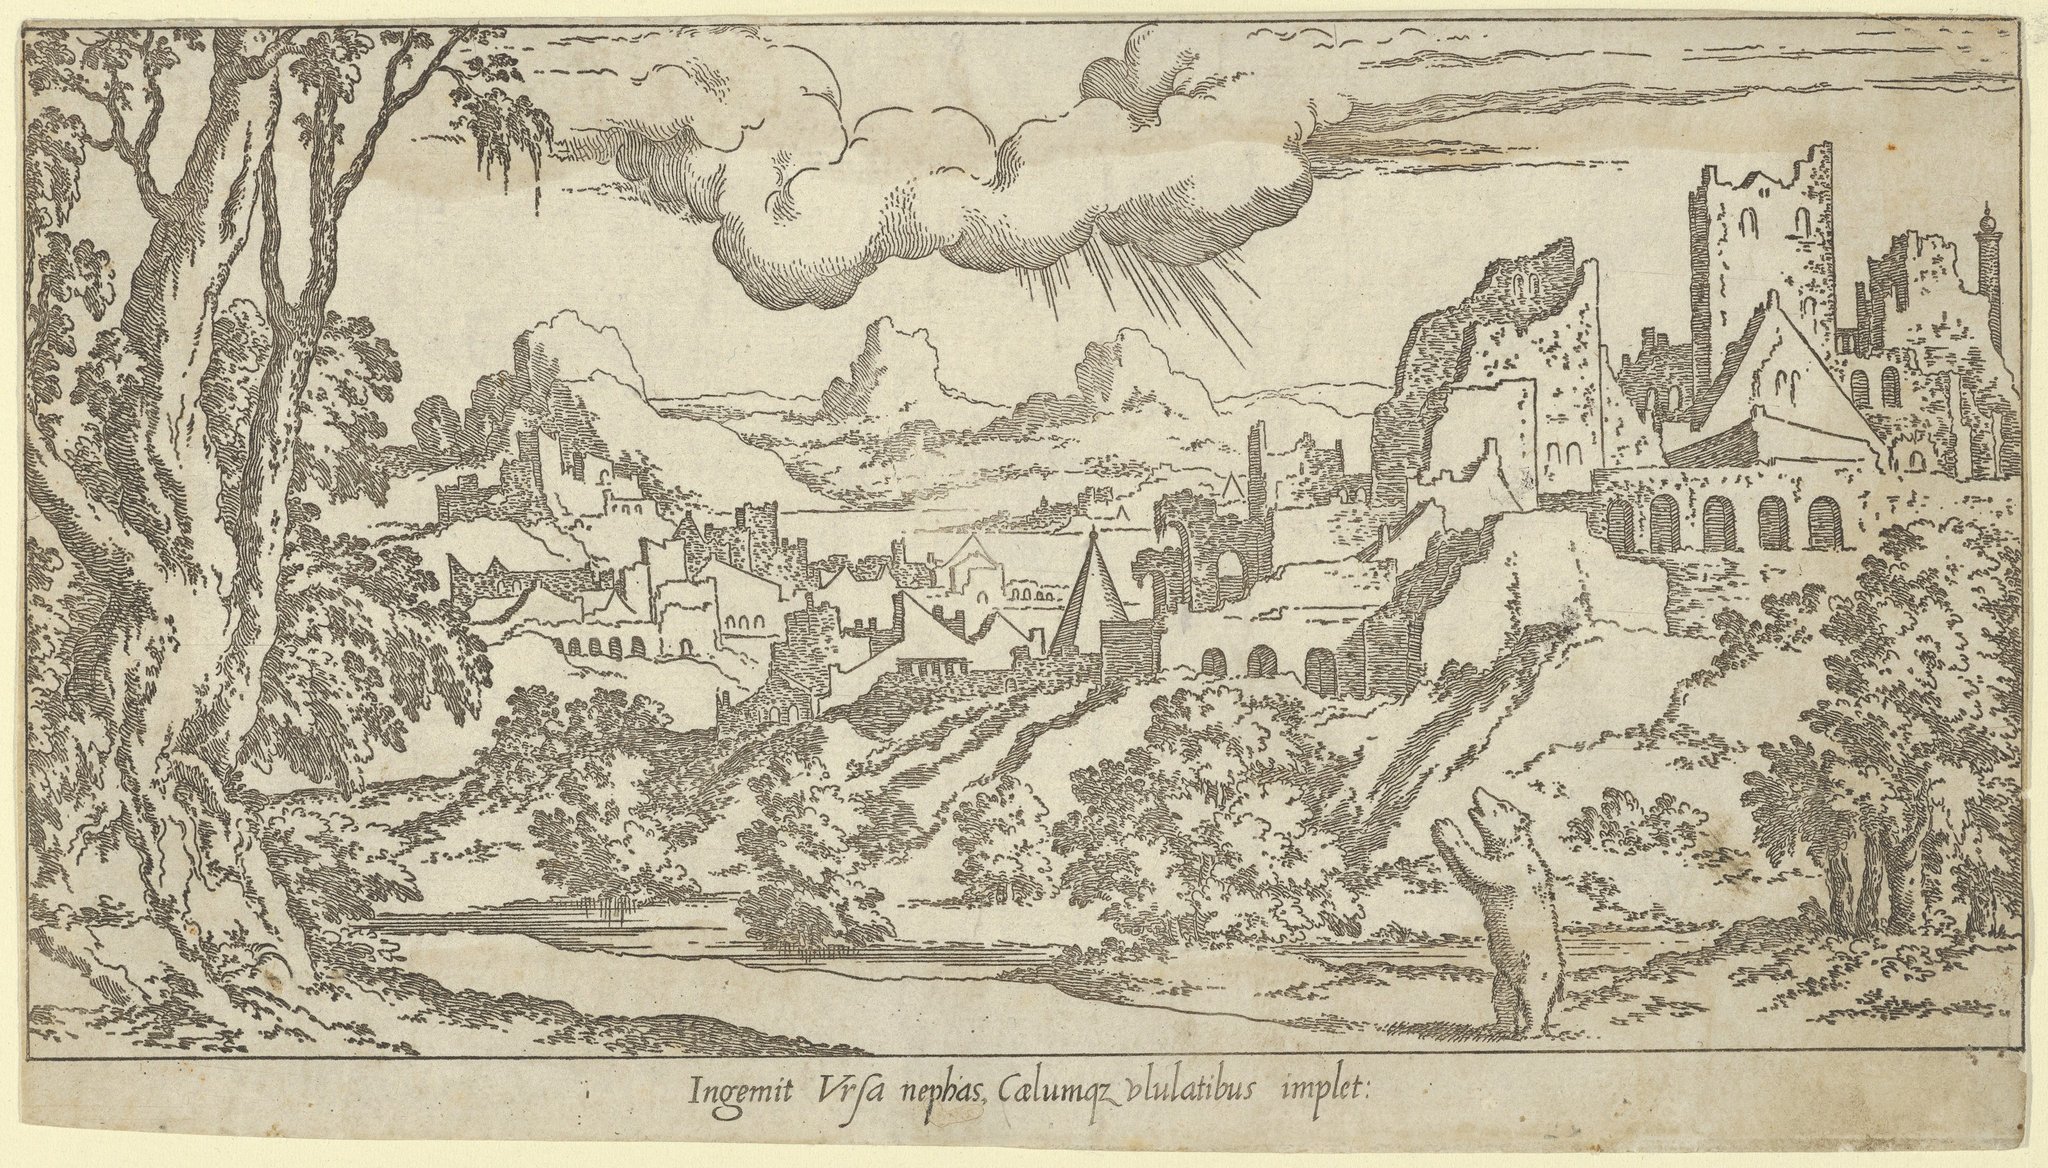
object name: print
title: Calisto Changed Into a Bear From Fable of Calisto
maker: léon davent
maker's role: artist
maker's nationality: french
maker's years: 1540-1556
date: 1547-1550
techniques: etching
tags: bears,trees